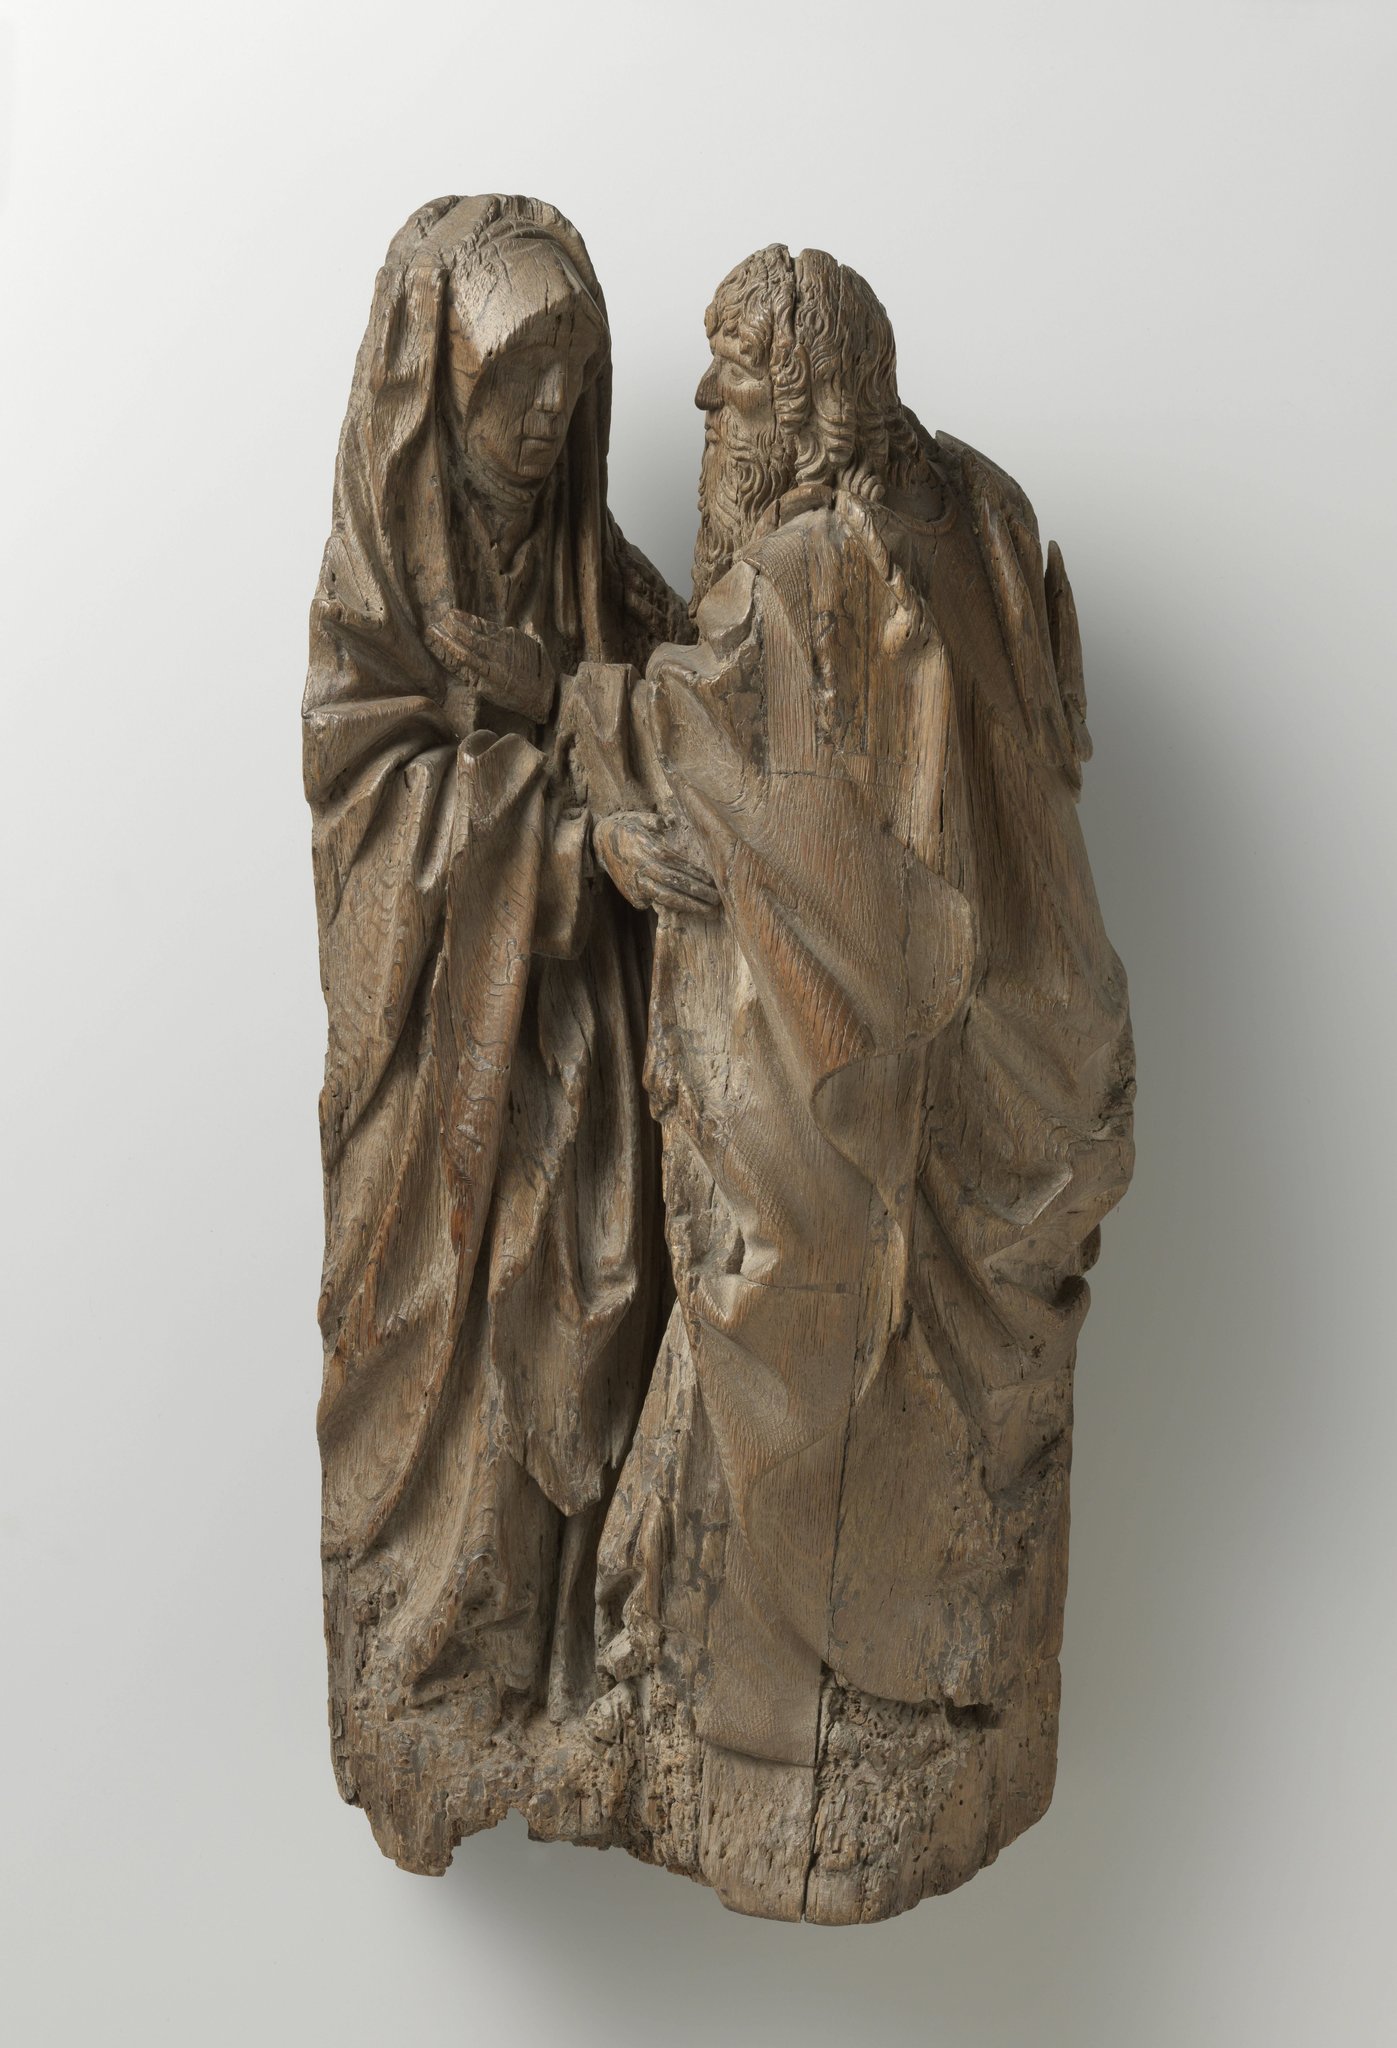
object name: sculpture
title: The Meeting of Joachim and Anne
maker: Anonymous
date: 1500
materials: wood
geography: cleves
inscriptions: inscription, on the reverse, in white paint: ‘B1728’